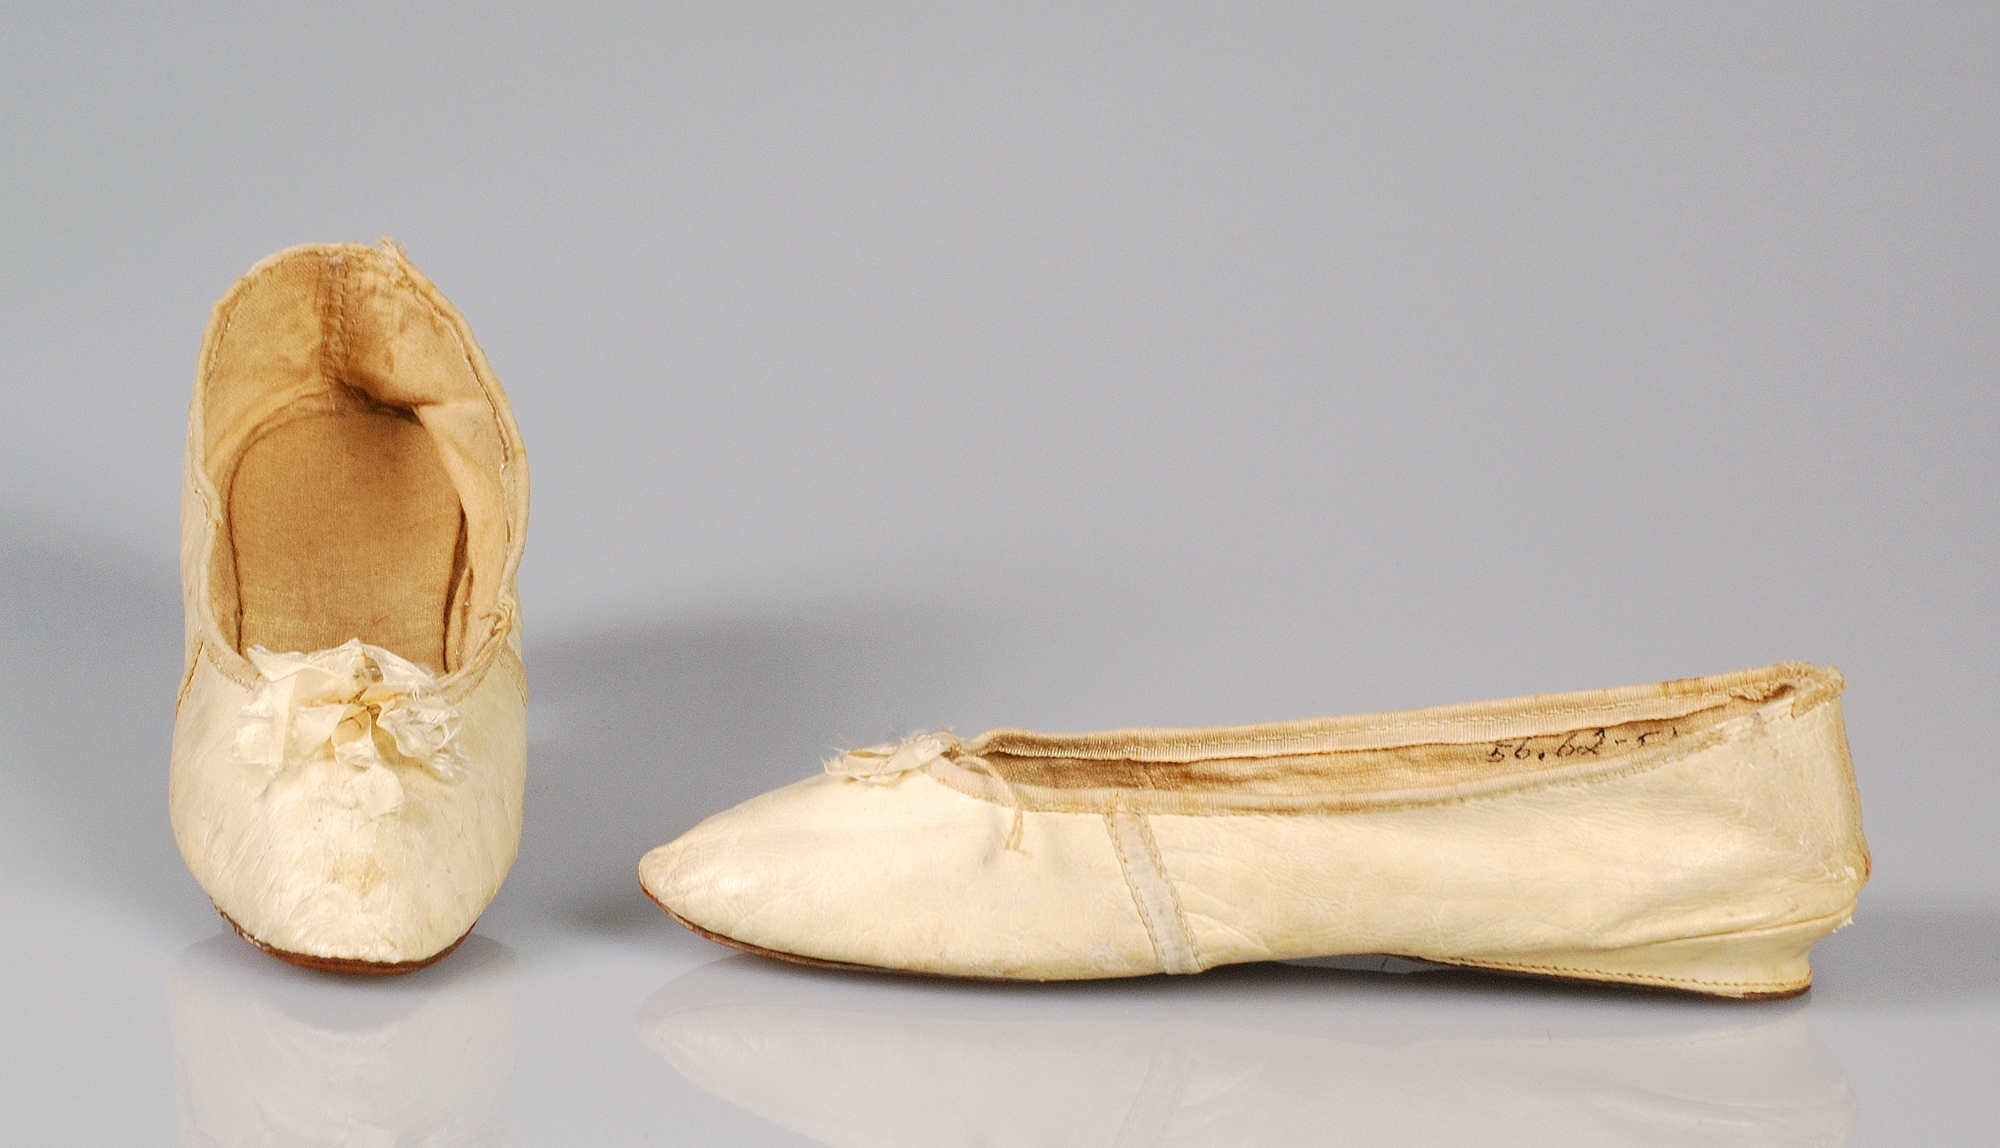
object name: wedding slipper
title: Wedding slippers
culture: american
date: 1810-1819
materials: leather, silk